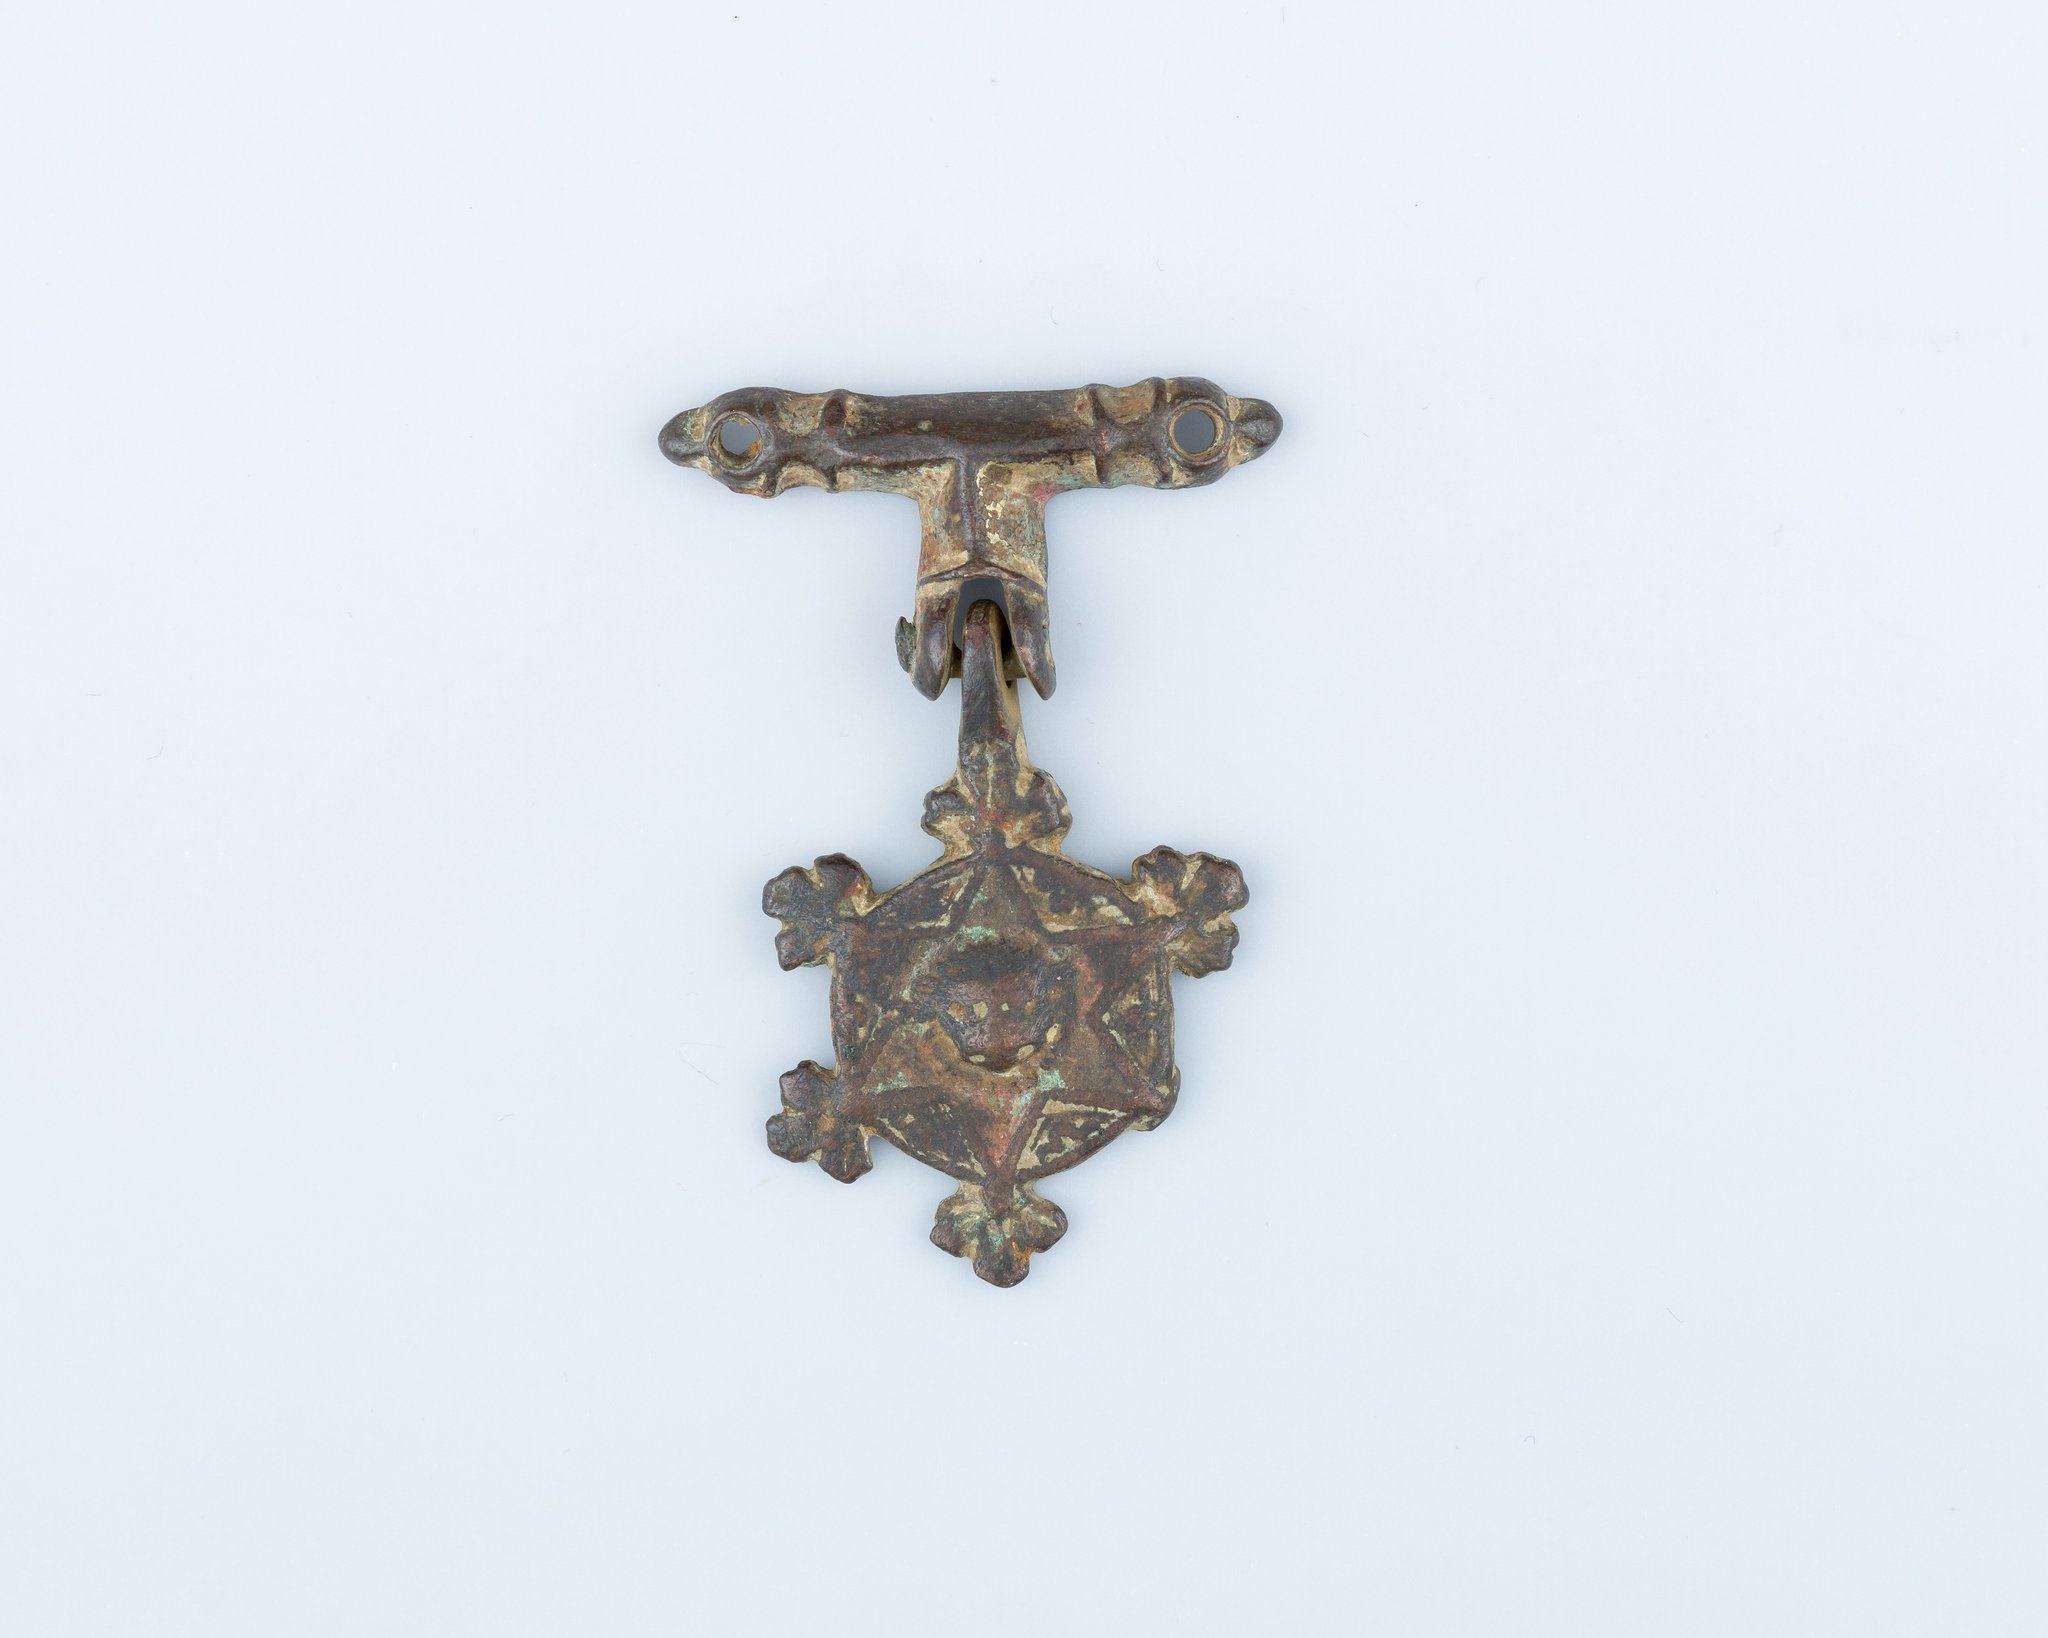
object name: ornament of horse trapping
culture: spanish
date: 1301-1400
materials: bronze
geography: spain